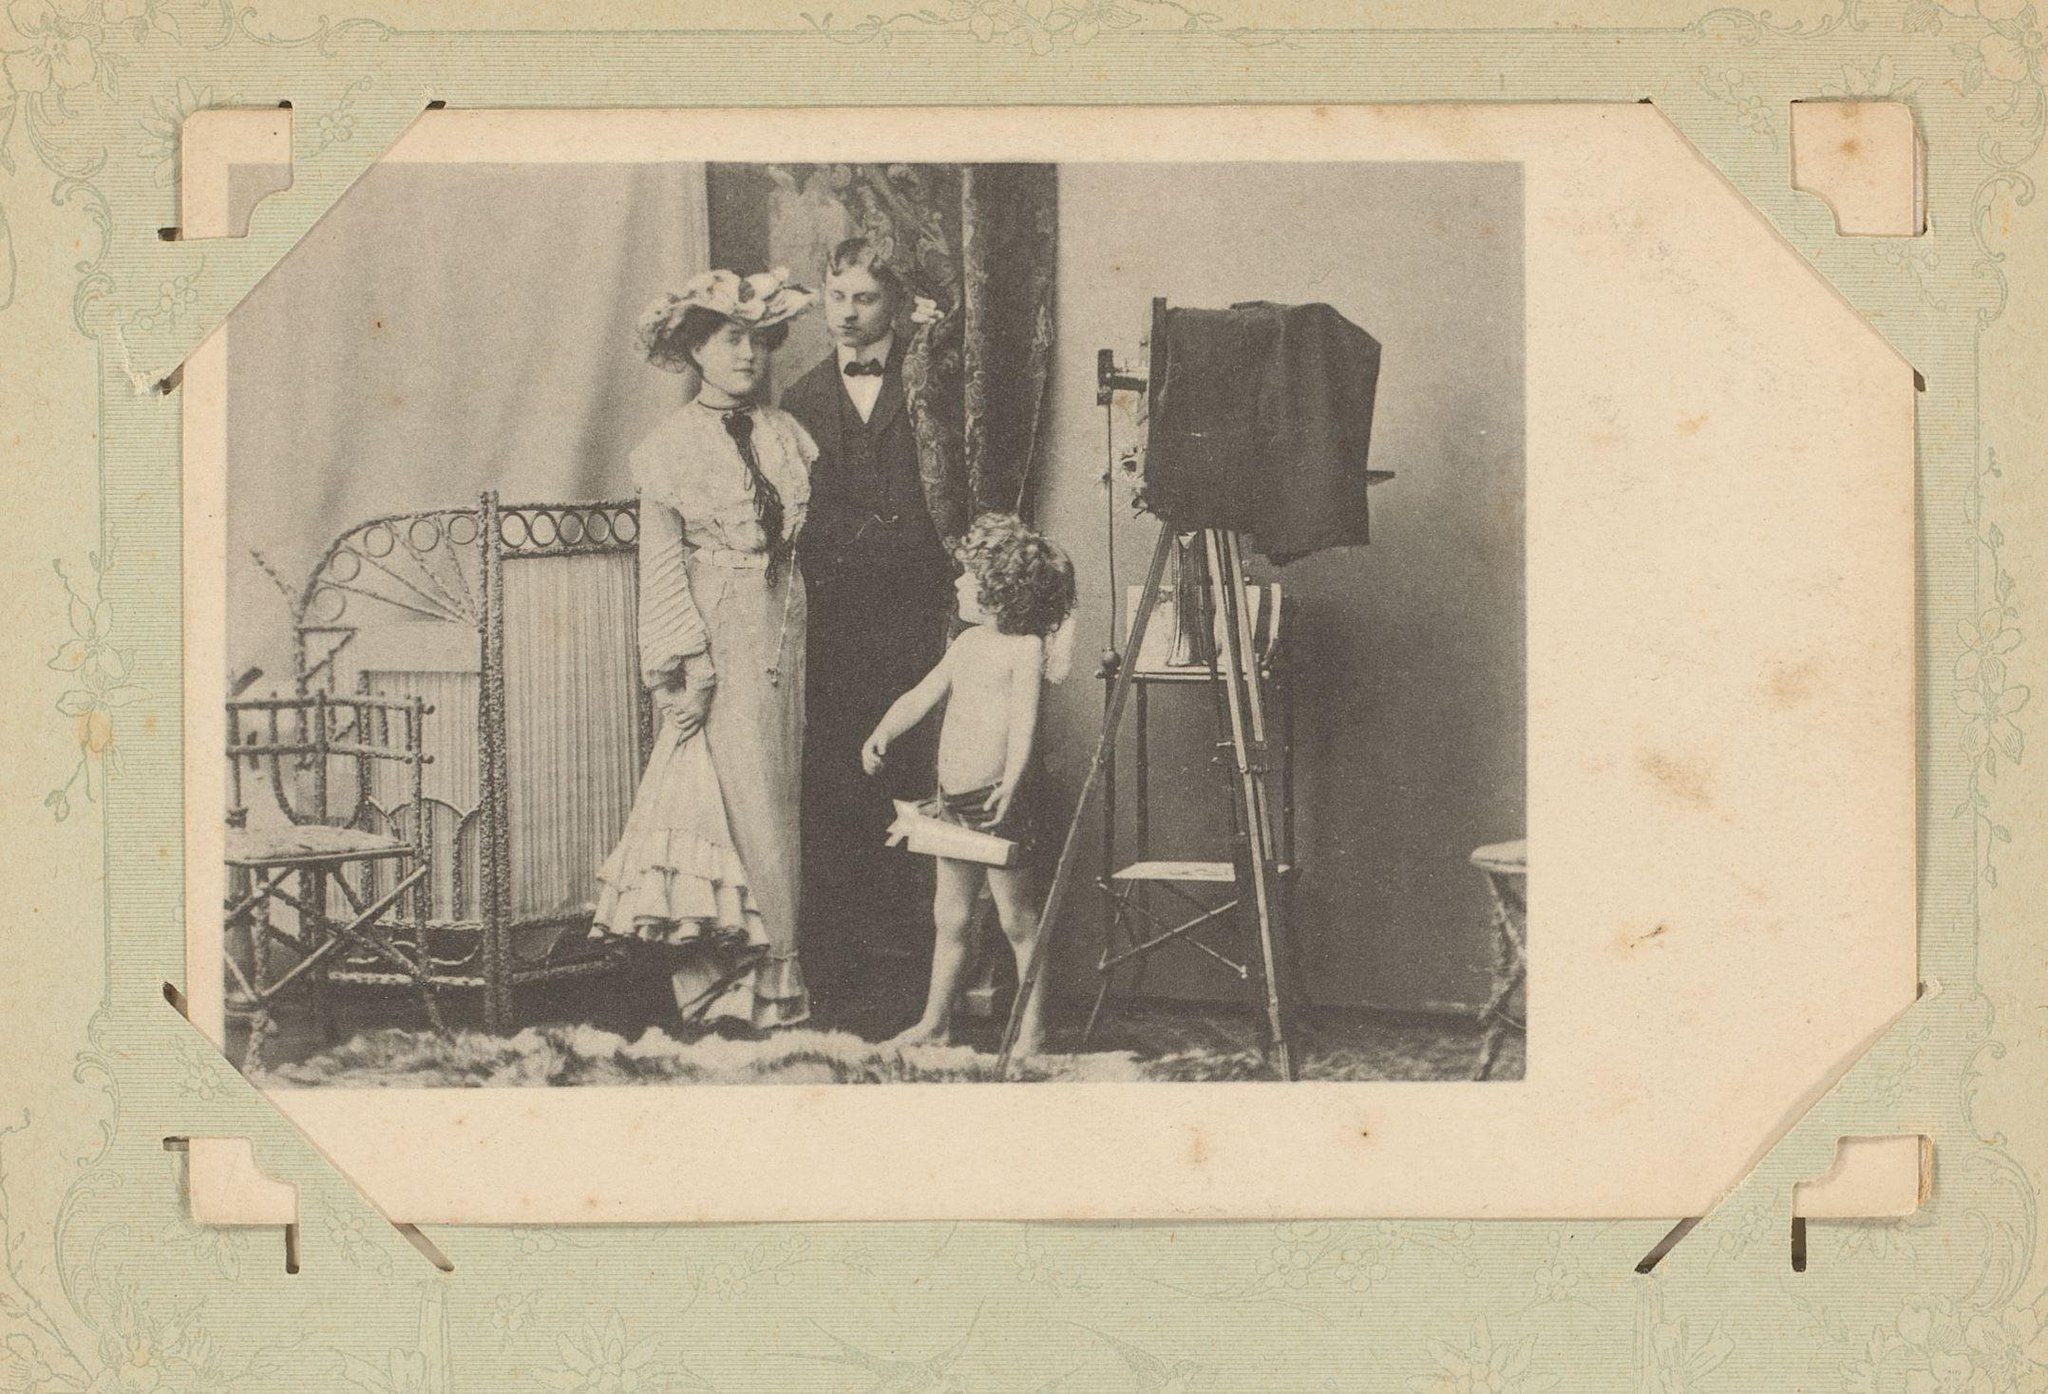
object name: ansichtkaart, prentbriefkaart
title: Man, vrouw en kind in een fotostudio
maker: Anonymous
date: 1900-1950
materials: cardboard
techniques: photograph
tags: studio ~ photographer, adult woman, camera ~ photography, adult man, child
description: Deze prent maakt deel uit van een album.